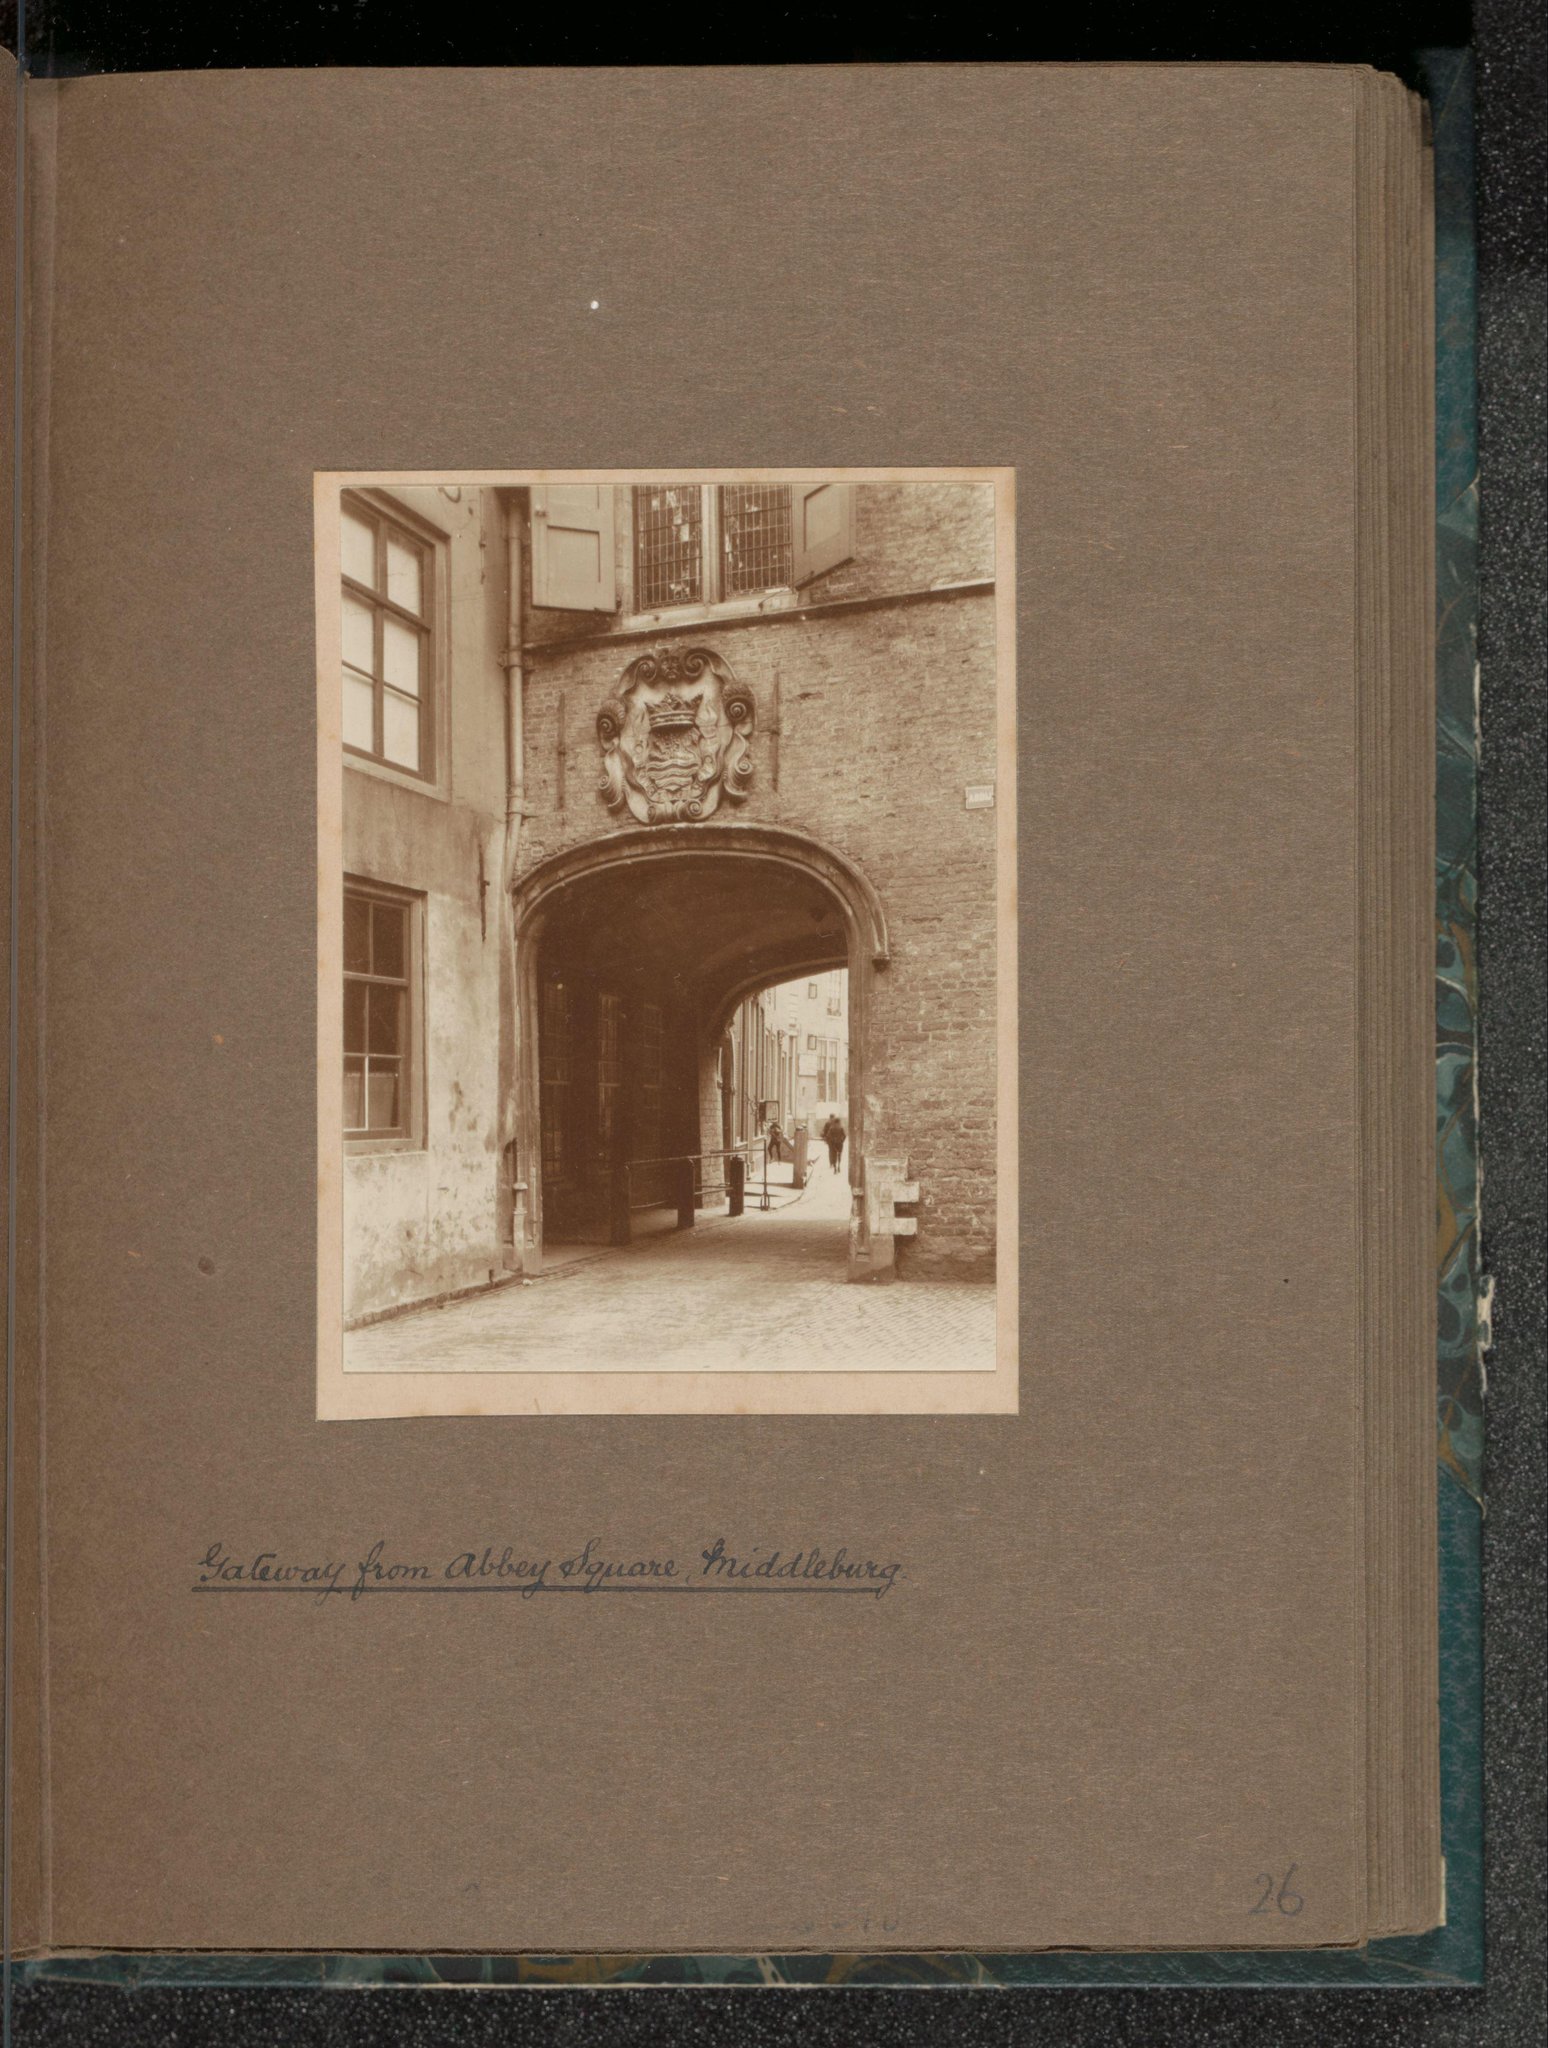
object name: photograph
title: Gateway from Abbey Square Middleburg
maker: Anonymous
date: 1912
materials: photographic support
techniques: gelatin silver print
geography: middelburg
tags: coat of arms (as symbol of the state, etc.), abbey, monastery, convent ~ roman catholic church, gate, entrance, travelling; tourism, middelburg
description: Onderdeel van Fotoalbum van de excursie naar Nederland van de Britse amateurfotografenvereniging P.C.U.K.